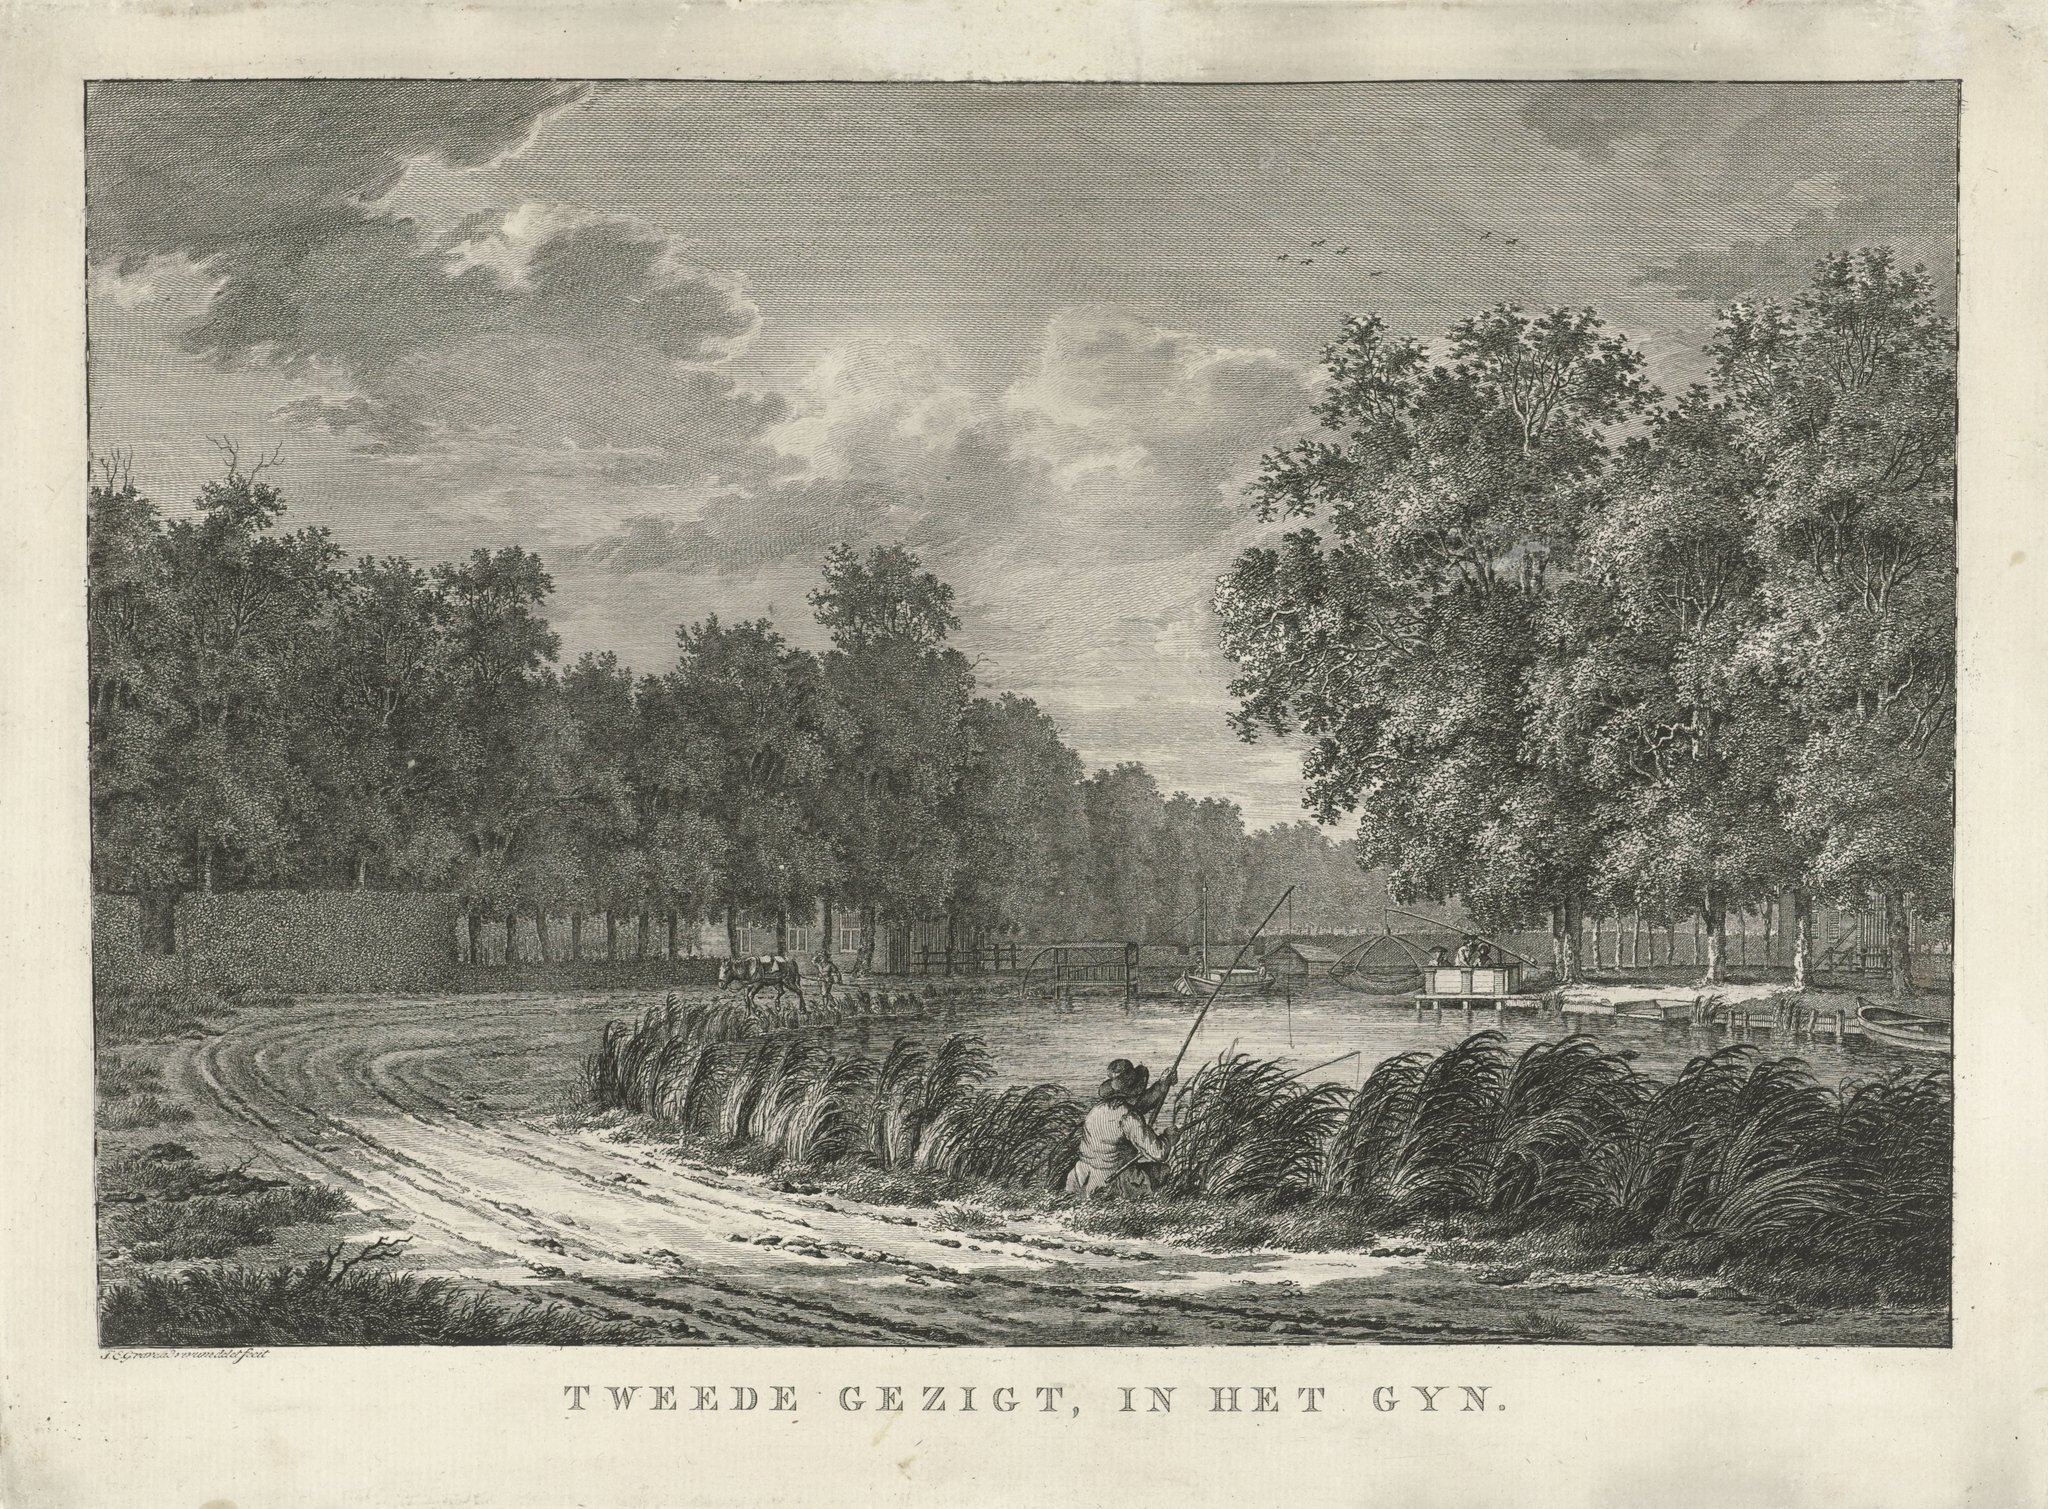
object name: print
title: Tweede Gezigt in het Gyn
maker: jan evert grave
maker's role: draughtsman, print maker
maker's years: 1759-1805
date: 1769-1805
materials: paper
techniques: engraving, etching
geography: amsterdam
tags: hunter, river (+ landscape with figures, staffage), angling, fisherman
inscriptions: collector's mark: Lugt 2228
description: De oever van de rivier het Gein bij Amsterdam. Op de voorgrond een hengelaar langs de weg. Op de achtergrond loopt een jager naast zijn paard.